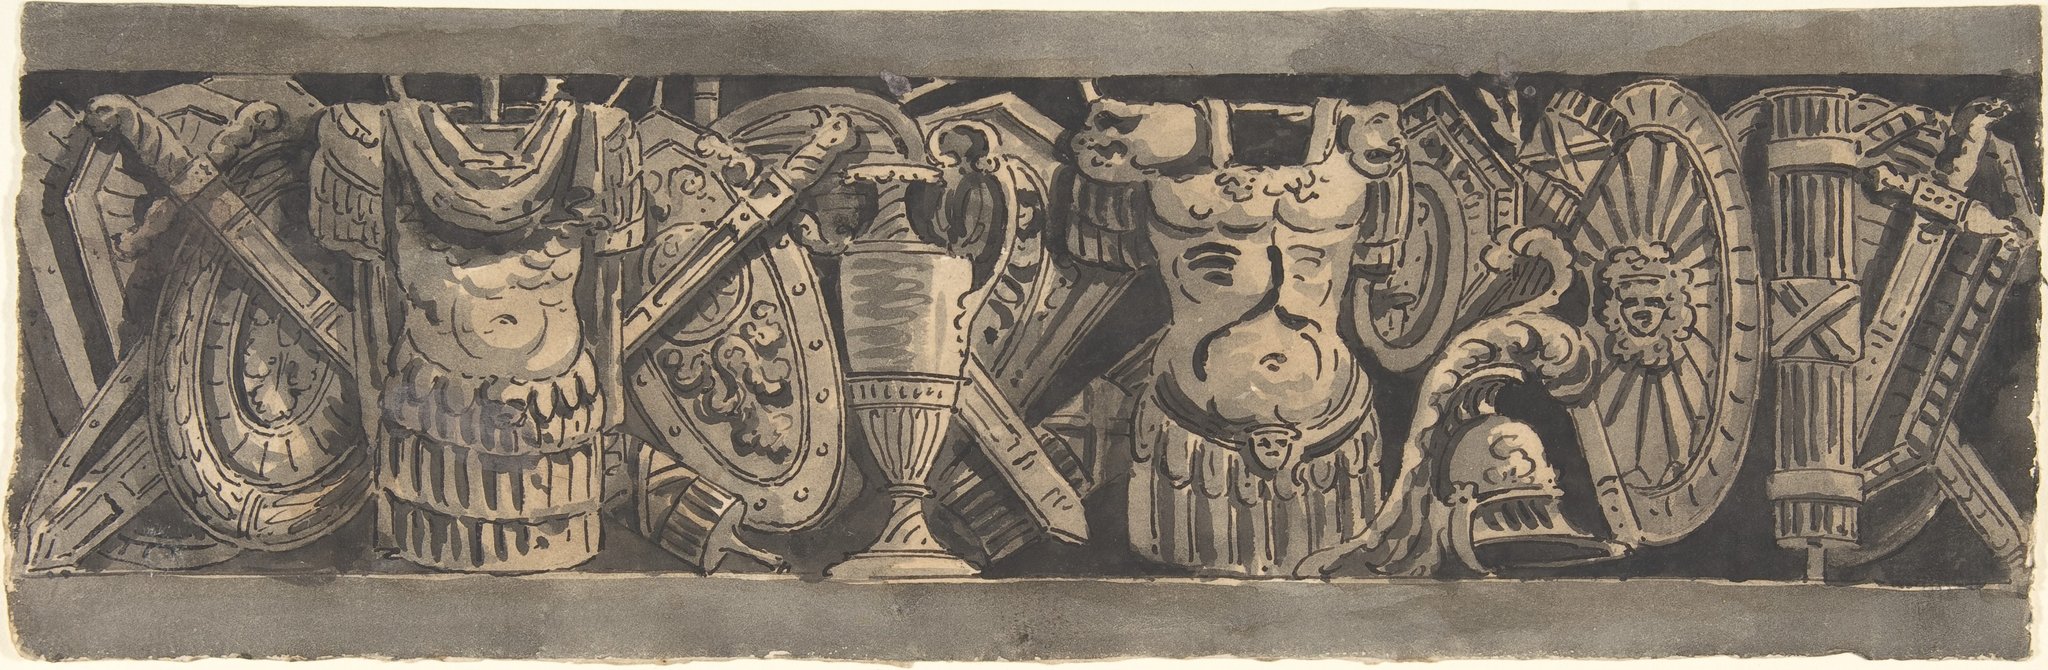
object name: drawing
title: Design for a Frieze with Roman Trophies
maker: anonymous, italian, 19th century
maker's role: artist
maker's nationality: italian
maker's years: 1800-1900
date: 1800-1900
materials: ink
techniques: wash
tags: trophies